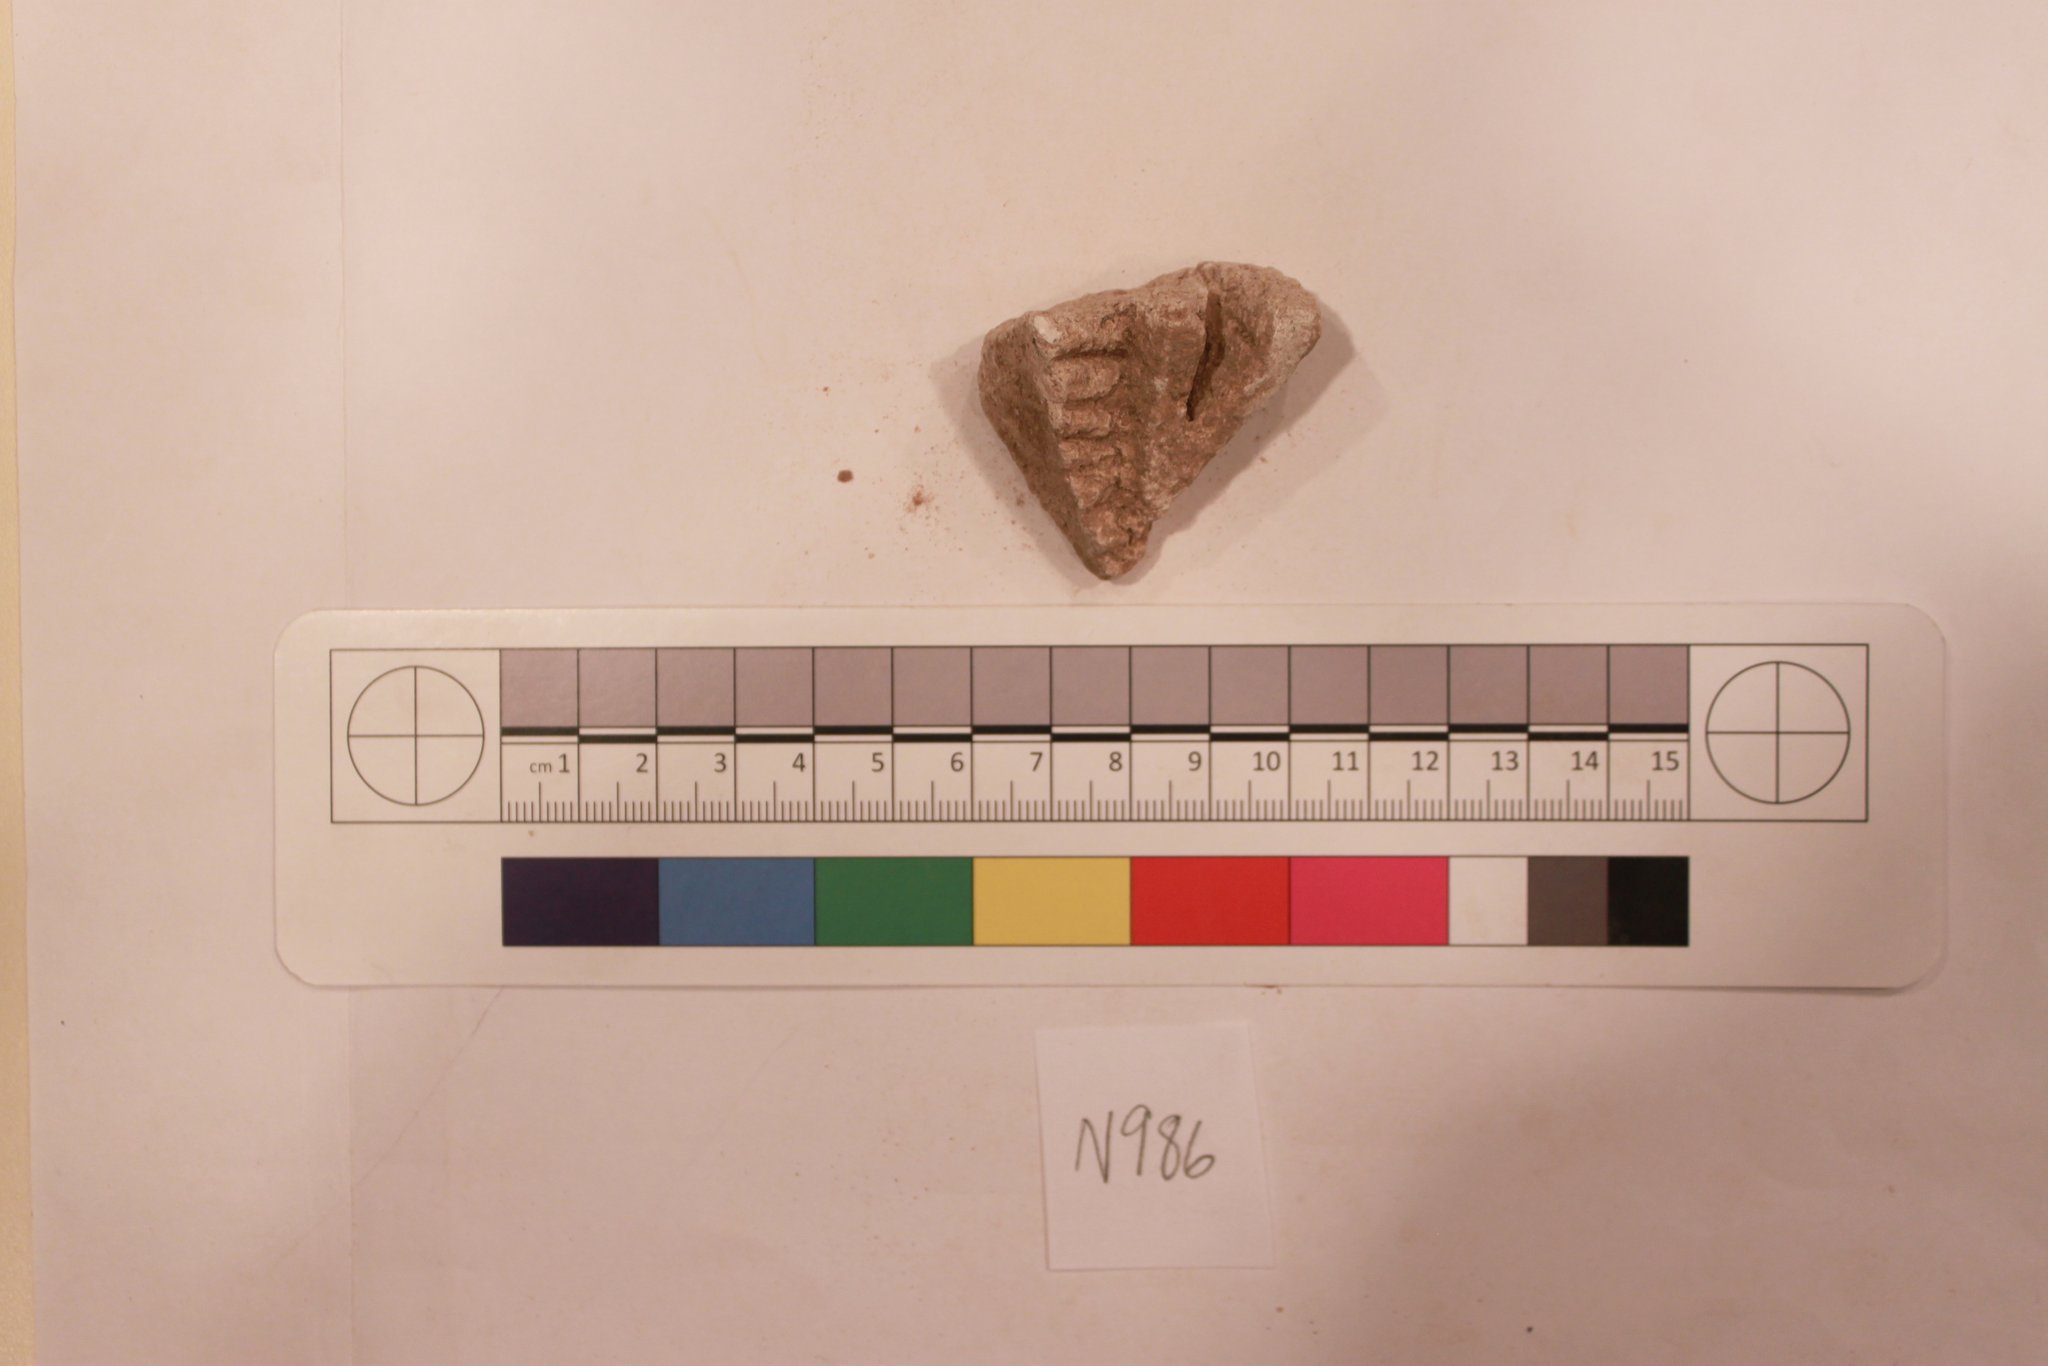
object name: fragment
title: Stucco Fragment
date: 701-1200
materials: plaster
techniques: carving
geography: iran